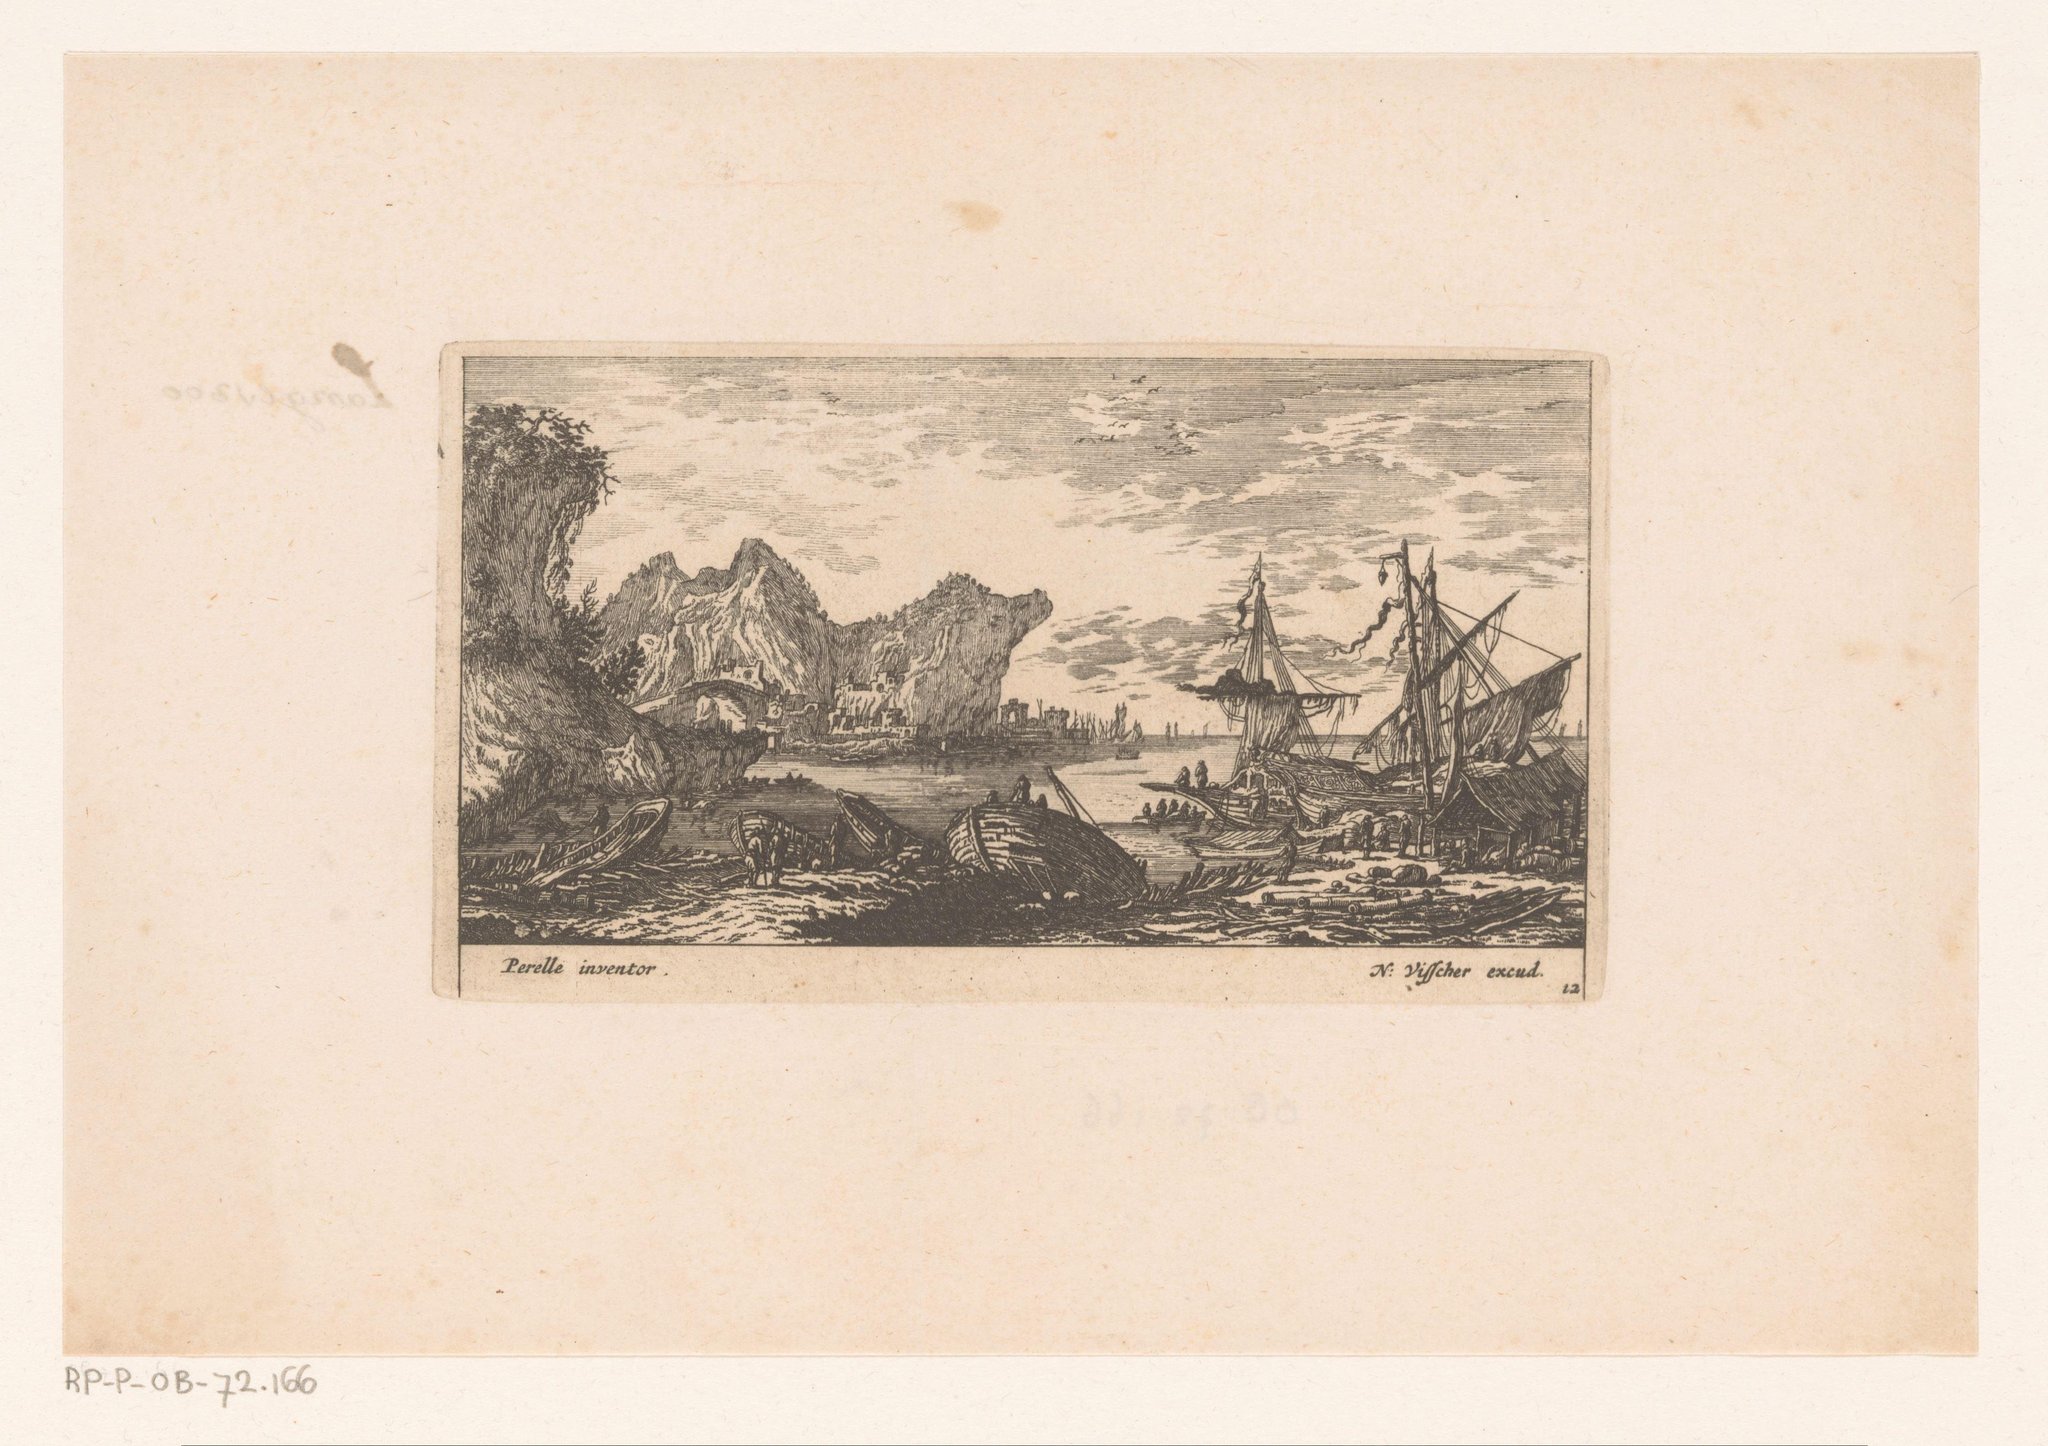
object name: print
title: Diverse zeehavens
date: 1628-1679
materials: paper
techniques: etching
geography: amsterdam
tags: harbour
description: Prenten met het signatuur 'Perelle' kunnen zowel door vader Gabriel als door zonen Nicolas en Adam gemaakt zijn.